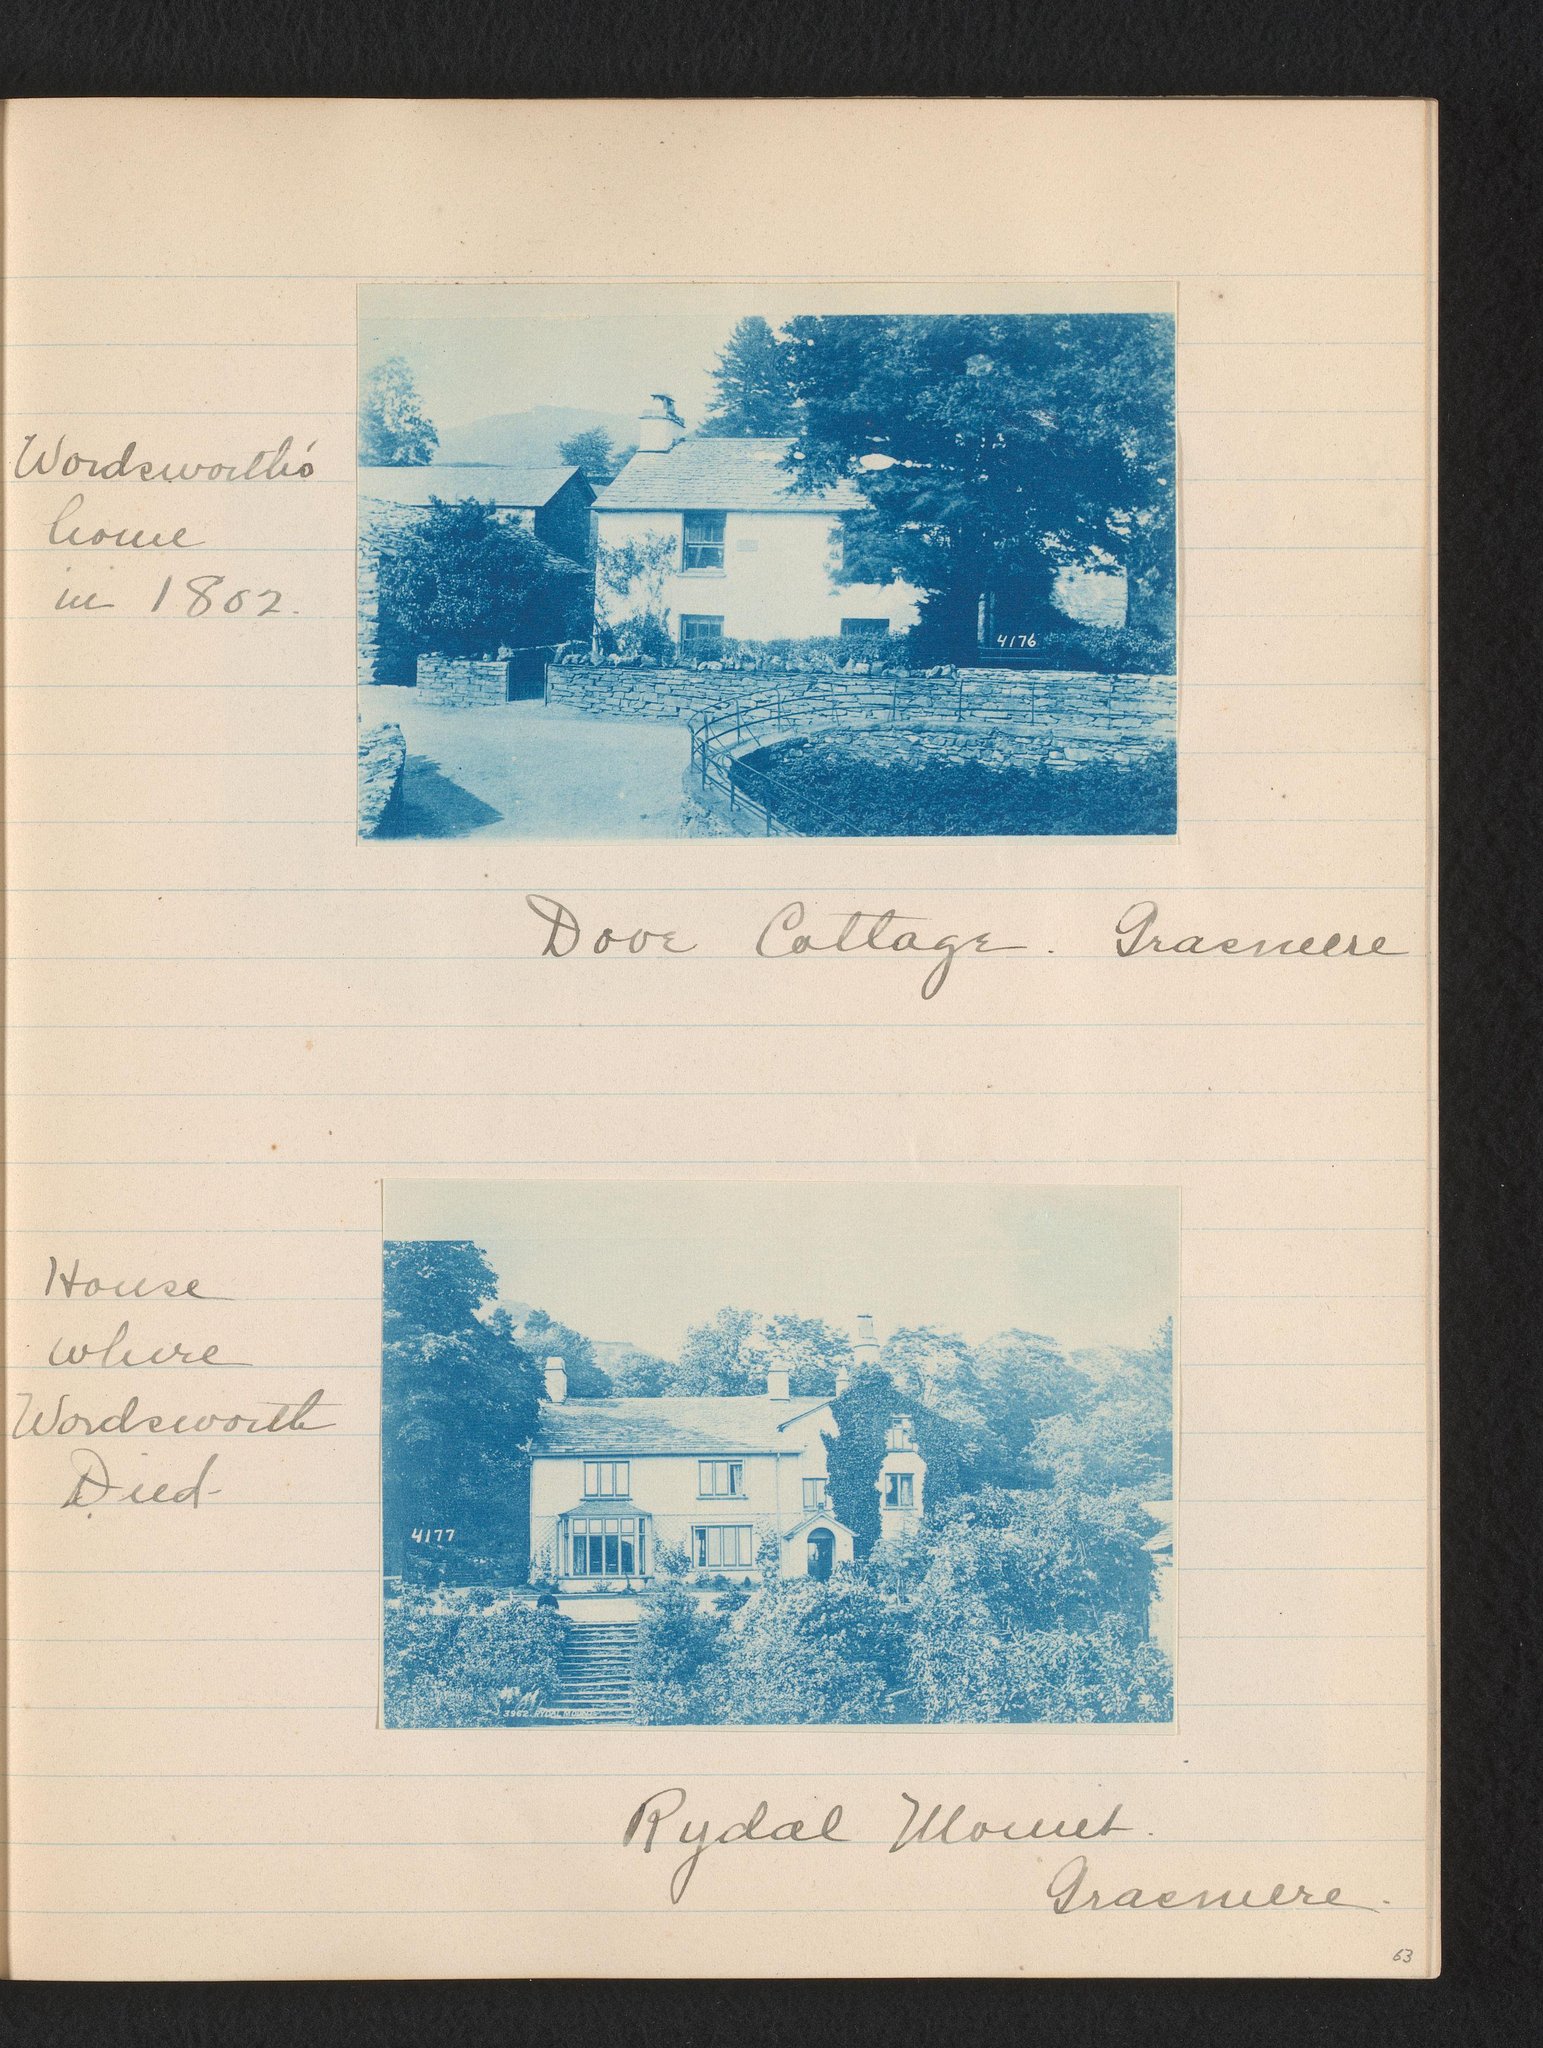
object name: photograph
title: Twee foto's van huizen waar William Wordsworth heeft gewoond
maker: Anonymous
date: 1901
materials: paper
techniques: cyanotype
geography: grasmere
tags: cottage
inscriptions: inscription: ‘Wordsworth/ home/ in 1802./ Dove Cottage, Gramsere/ House/ where/ Wordsworth/ Died./ Rydal Mount,/ Grasmere’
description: Deze foto's maken deel uit van een album.